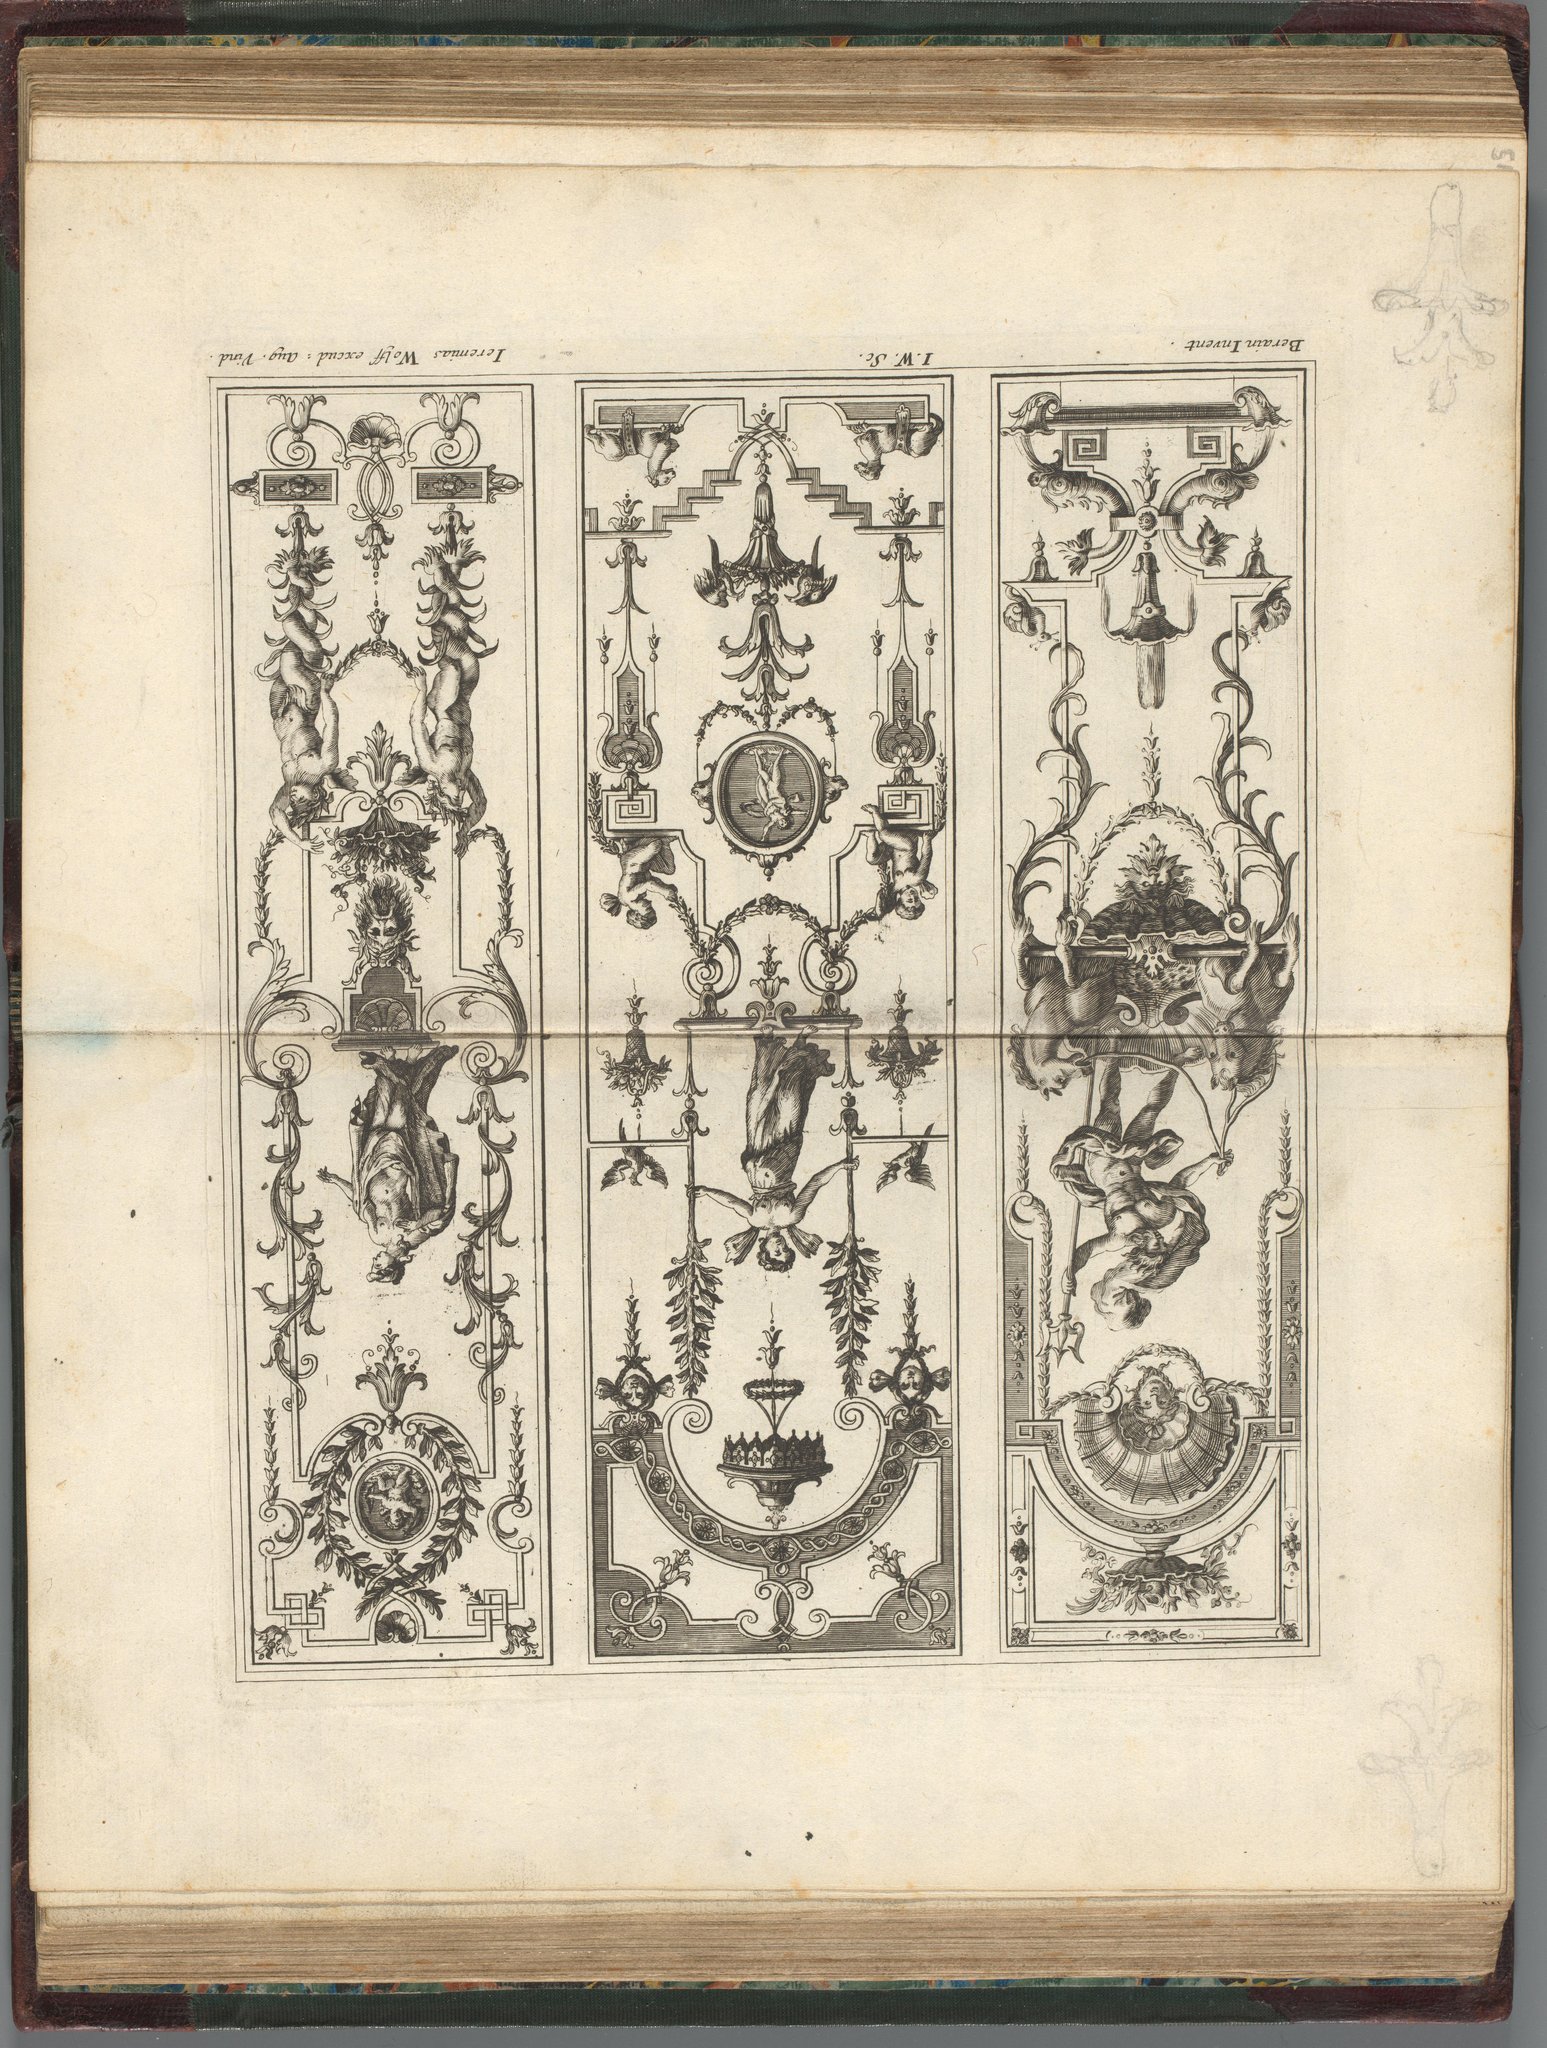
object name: print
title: Compositie met Neptunus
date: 1686-1724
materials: paper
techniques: etching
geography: augsburg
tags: (story of) neptune (poseidon), ornaments ~ art, triton(s), mask, mascaron ~ ornament, attributes of neptune: trident, attributes of neptune (with name)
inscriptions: signature: ‘I. W. Sc.’, signature: ‘Berain Invent’, signature: ‘Ieremias Wolff excud: Aug. Vind.’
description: Een decoratieve compositie bestaand uit drie panelen. Links de god Neptunus met zijn drietand staande in een schelp voortgetrokken door twee paarden. In het midden een engel onder een baldakijn met daaronder een medaillon met een ontvoeringsscène. Rechts een godin op een plateau met daaraan een masker en daaronder twee tritons. Prent maakt deel uit van een album. Hoogstwaarschijnlijk gespiegelde kopie naar Frans origineel.